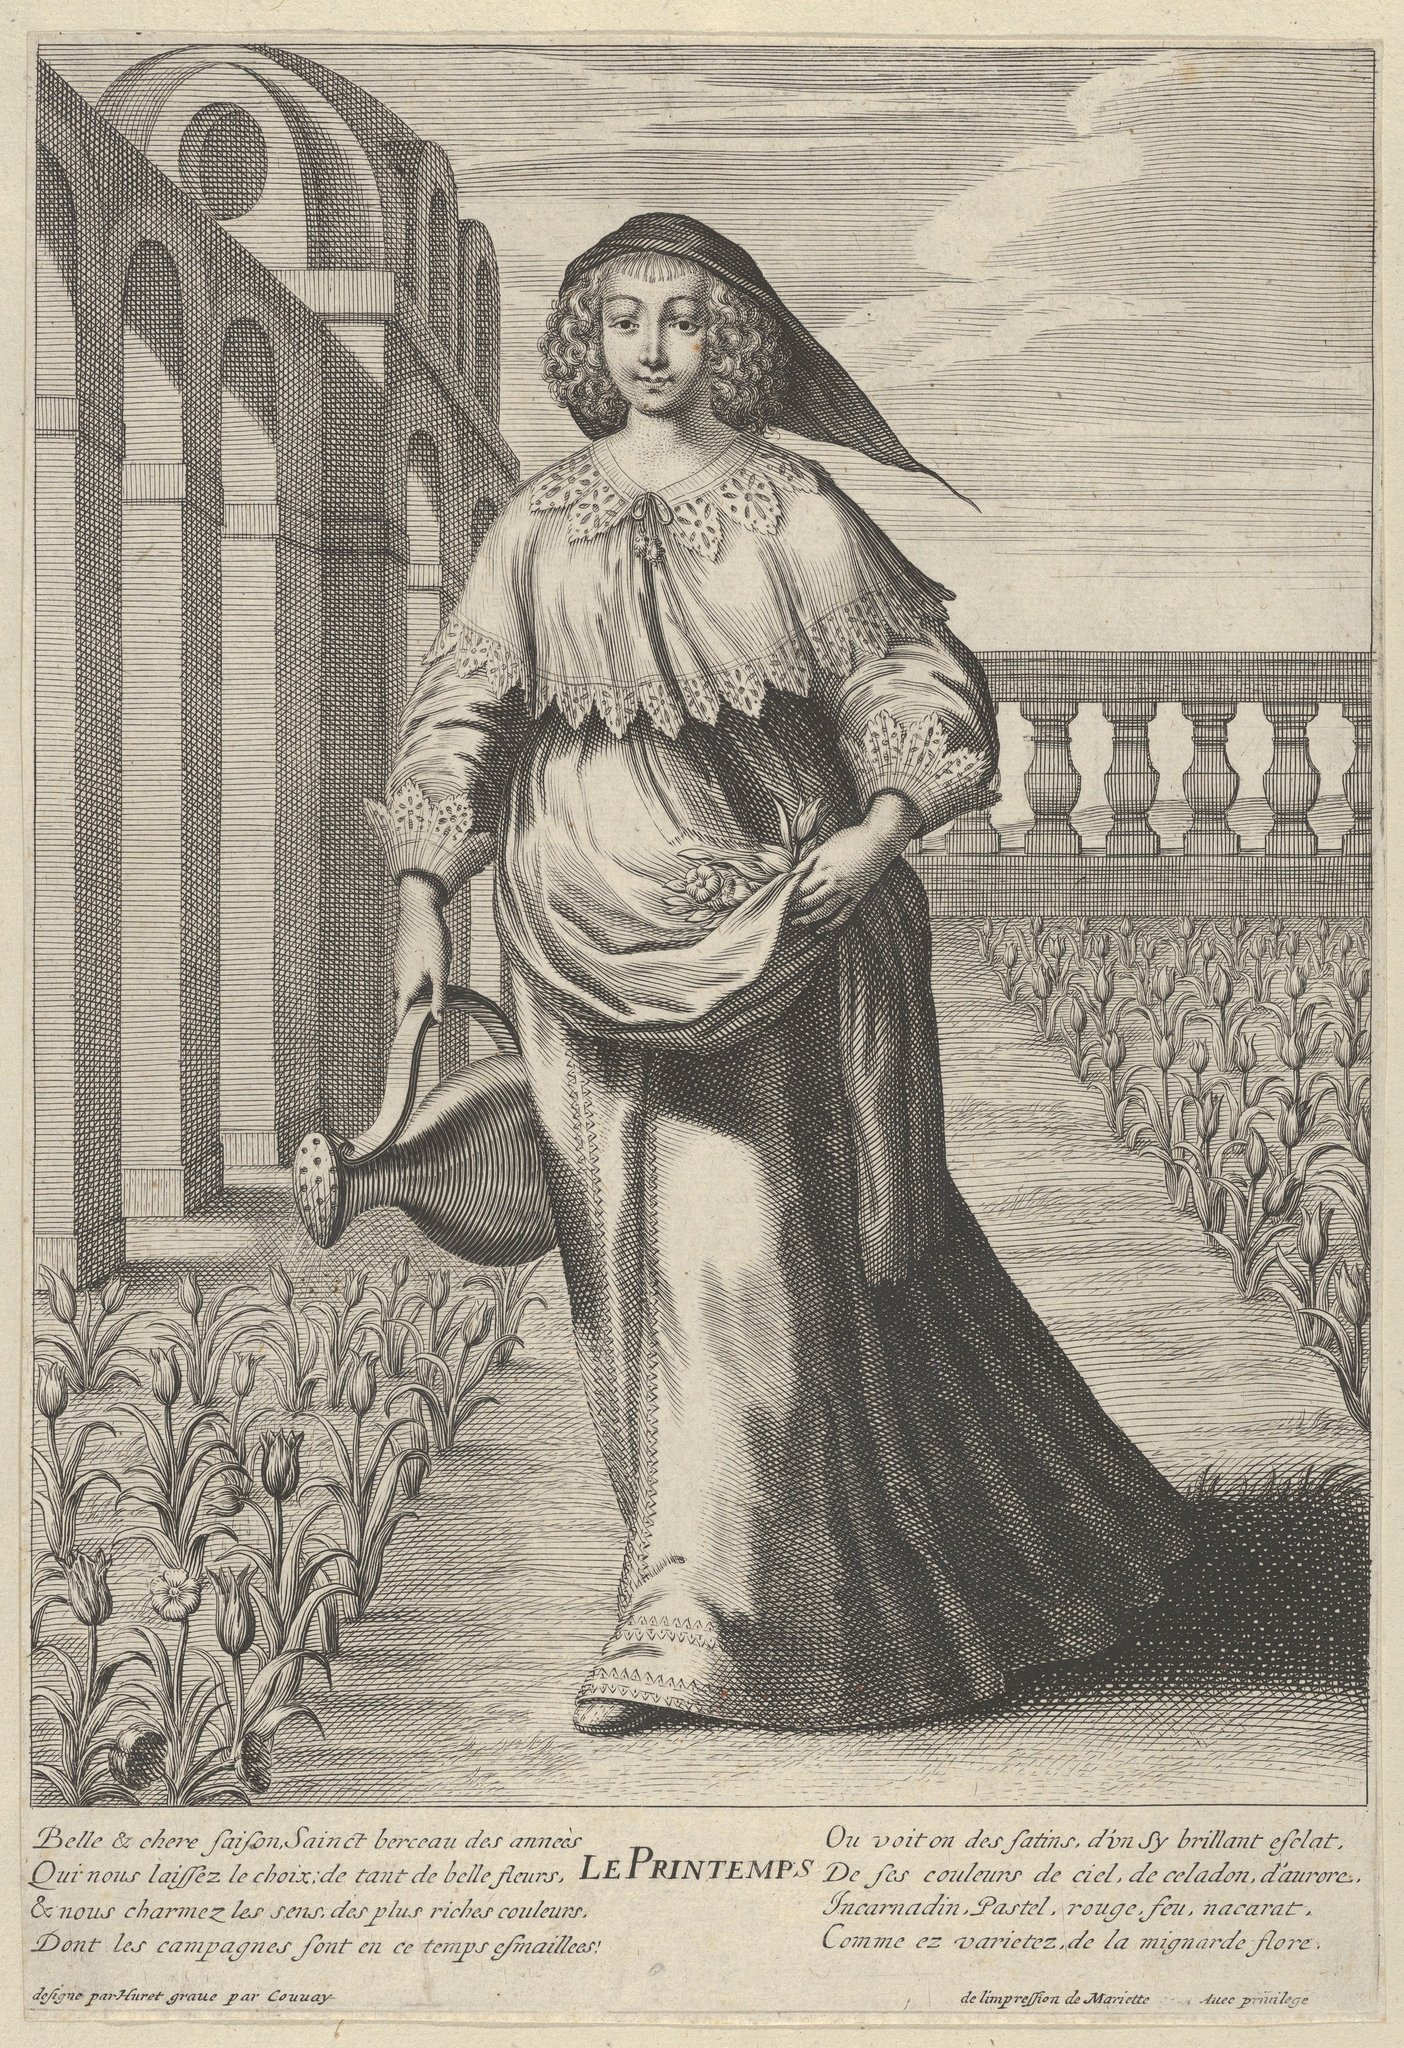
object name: print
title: Spring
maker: jean couvay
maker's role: artist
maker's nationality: french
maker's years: 1600-1663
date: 1601-1700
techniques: engraving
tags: gardens,women,flowers